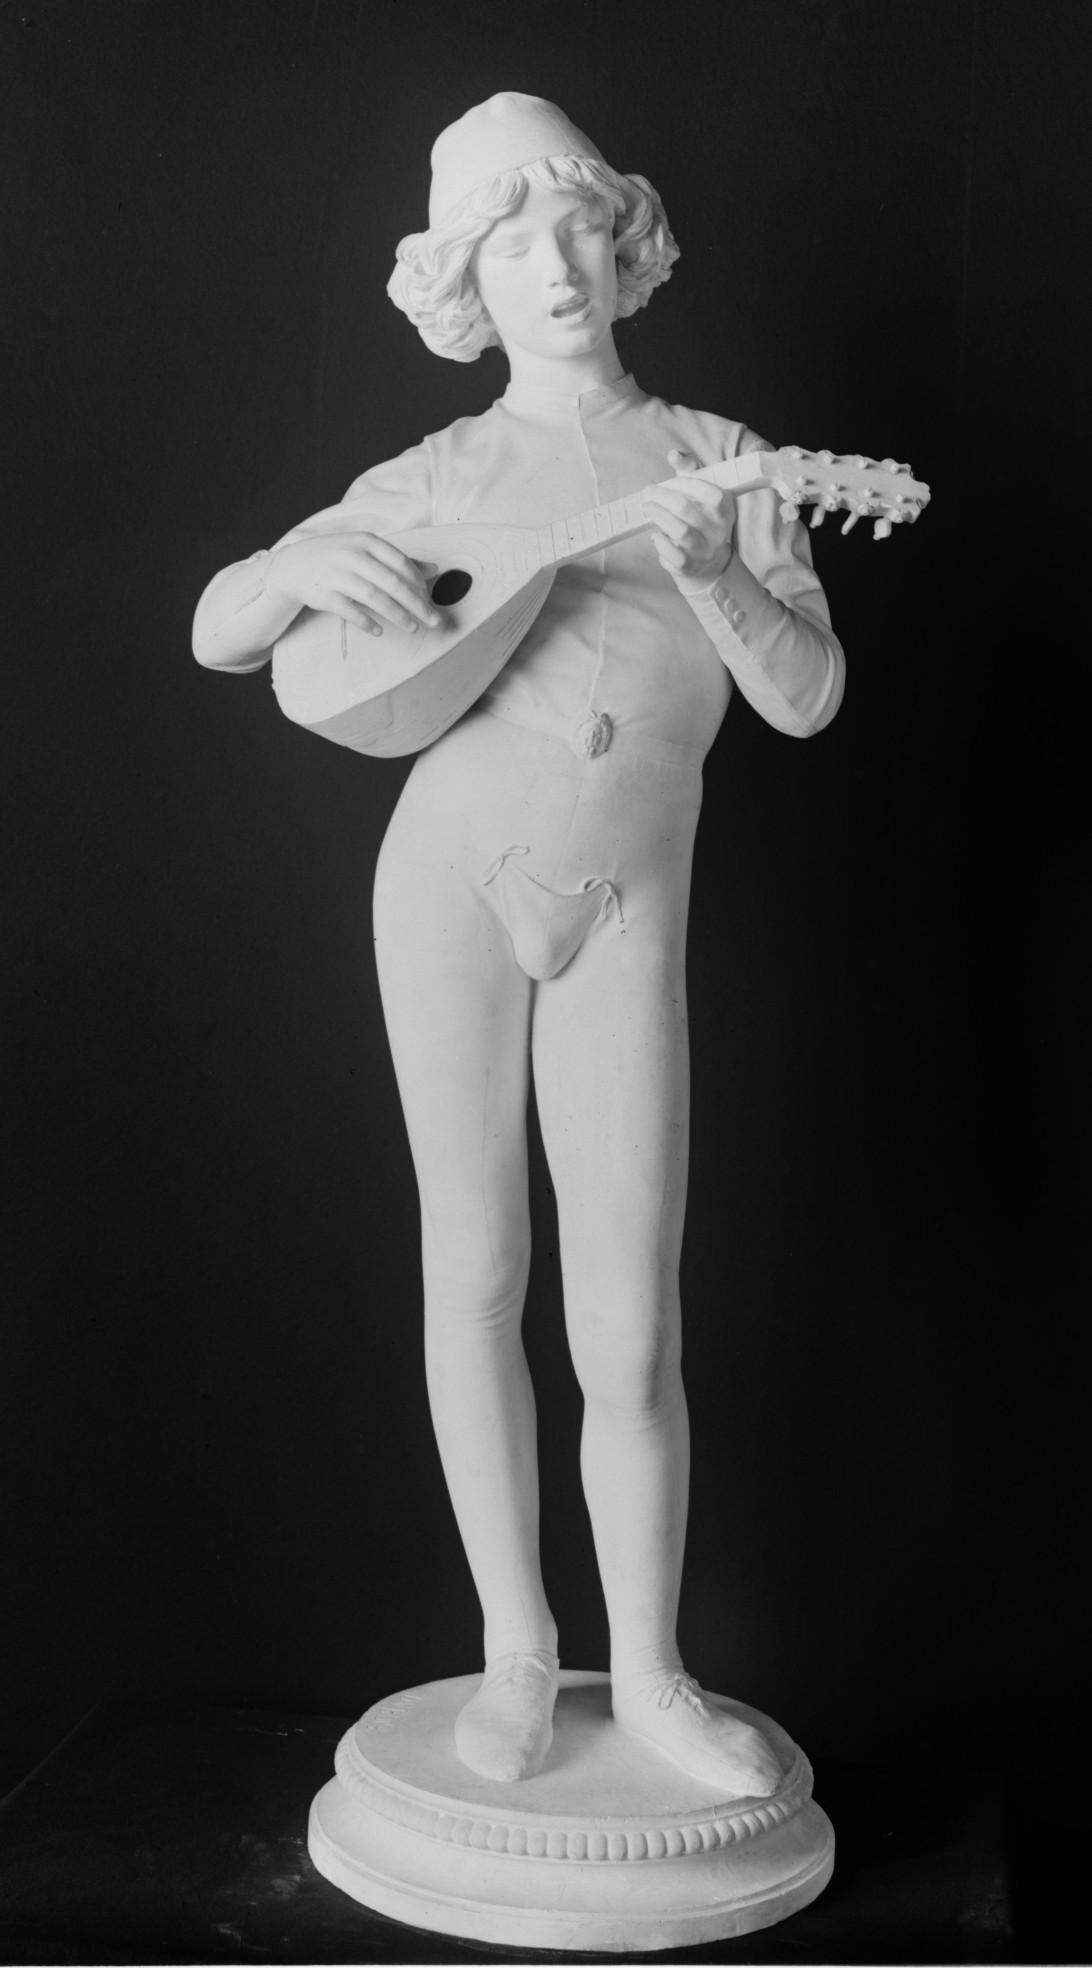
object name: statuette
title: Florentine Singer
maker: paul dubois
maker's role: artist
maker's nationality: french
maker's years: 1829-1905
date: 1865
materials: plaster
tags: musical instruments,men,singers